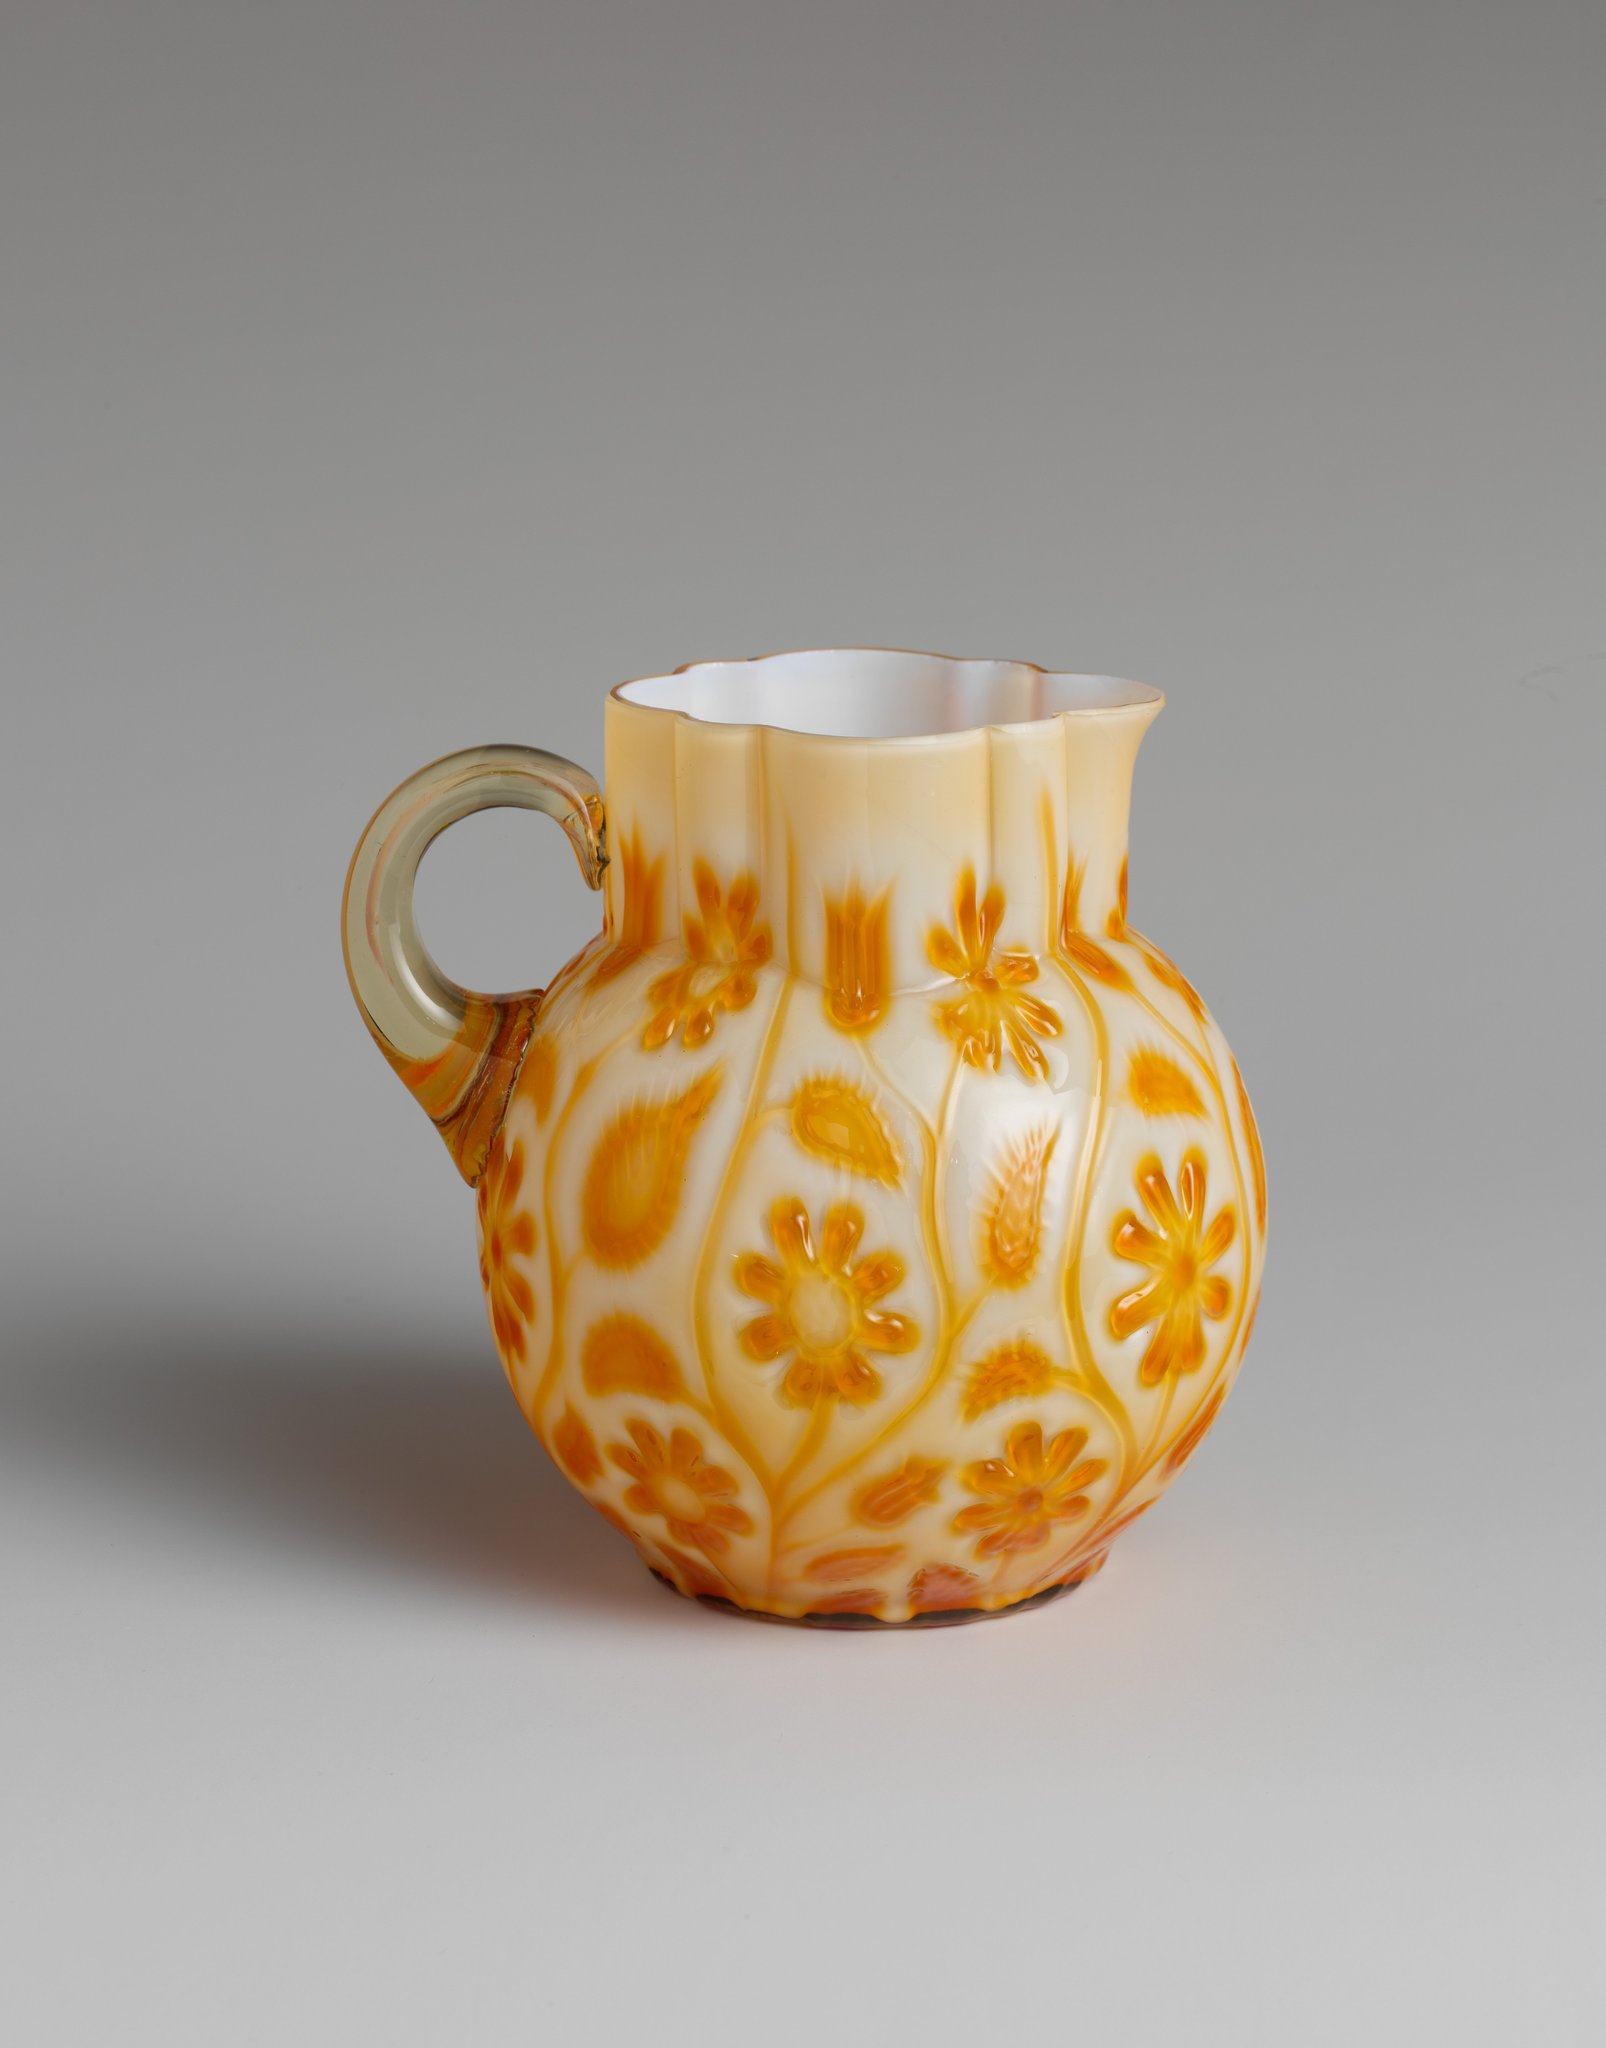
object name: cream pitcher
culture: american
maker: dalzell, gilmore and leighton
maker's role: maker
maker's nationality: american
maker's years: 1885-1898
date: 1886-1890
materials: glass, onyx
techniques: glassblowing, molding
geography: united states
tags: flowers